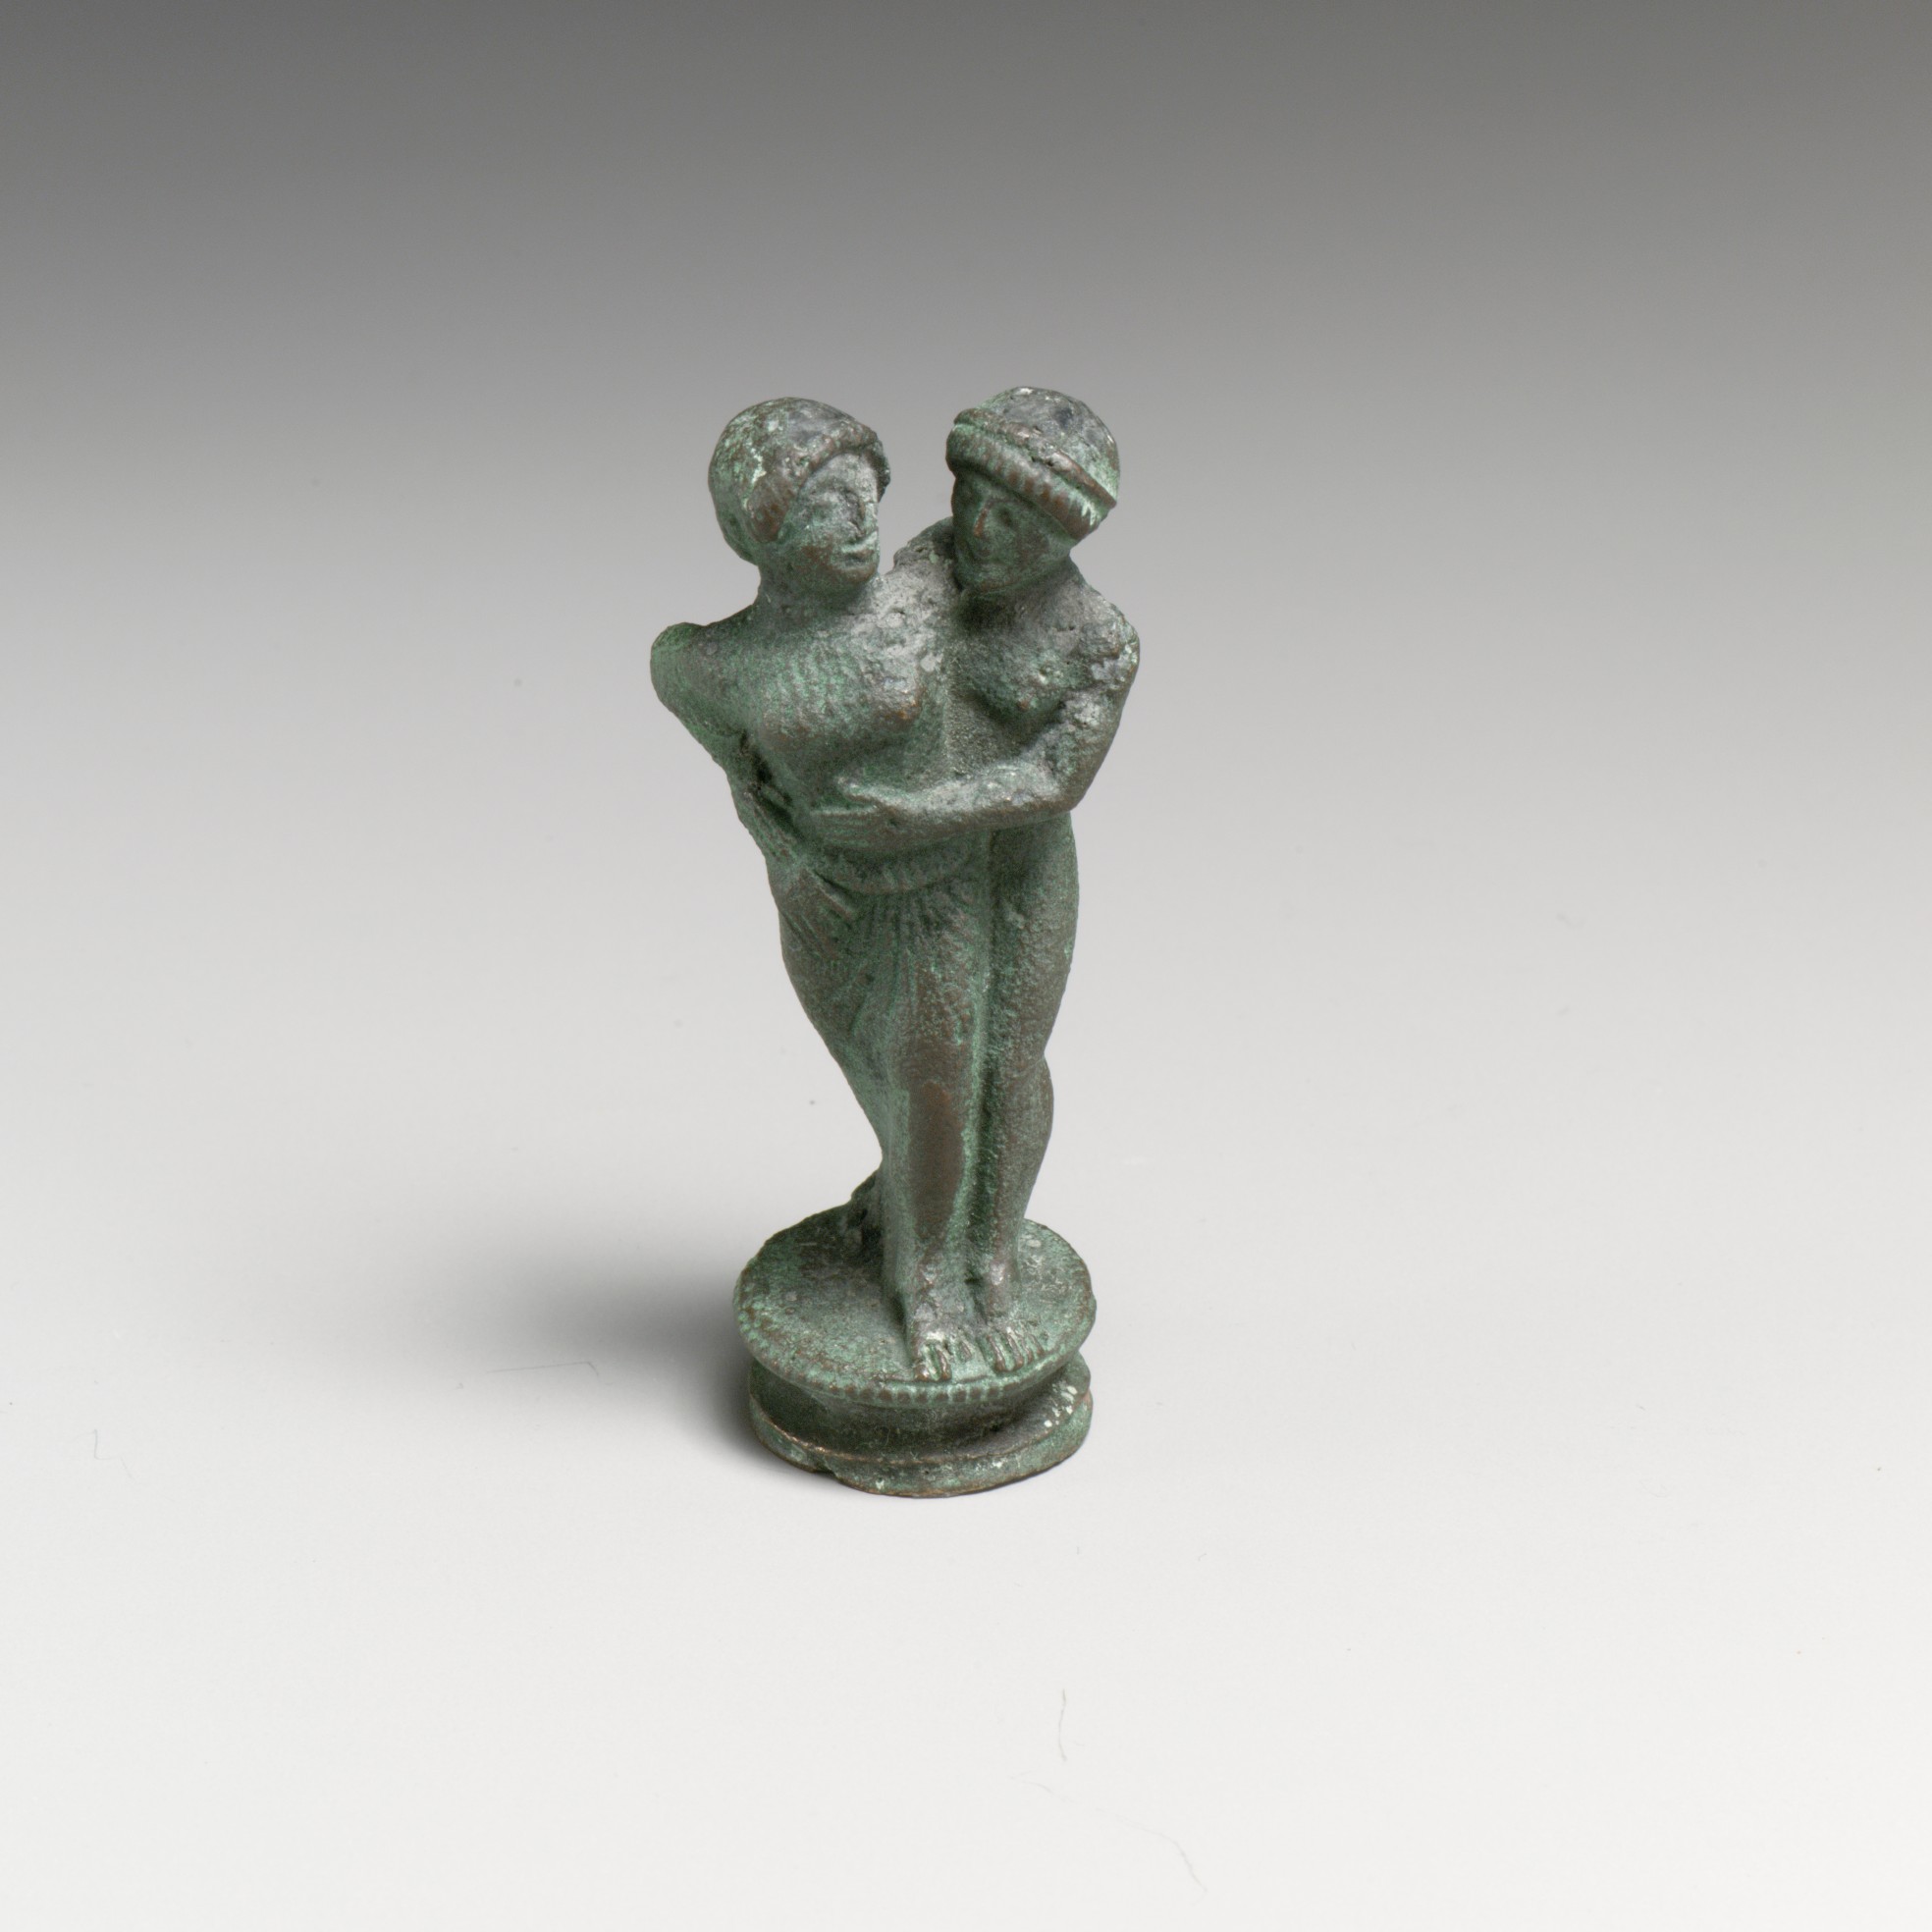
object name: statuette of a youth and a girl from candelabrum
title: Bronze candelabrum finial showing a man embracing a woman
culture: etruscan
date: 500-401 BCE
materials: bronze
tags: men,women